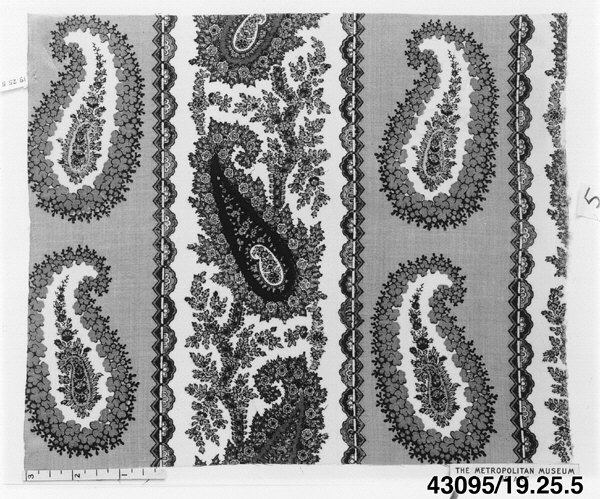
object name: sample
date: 1830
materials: wool